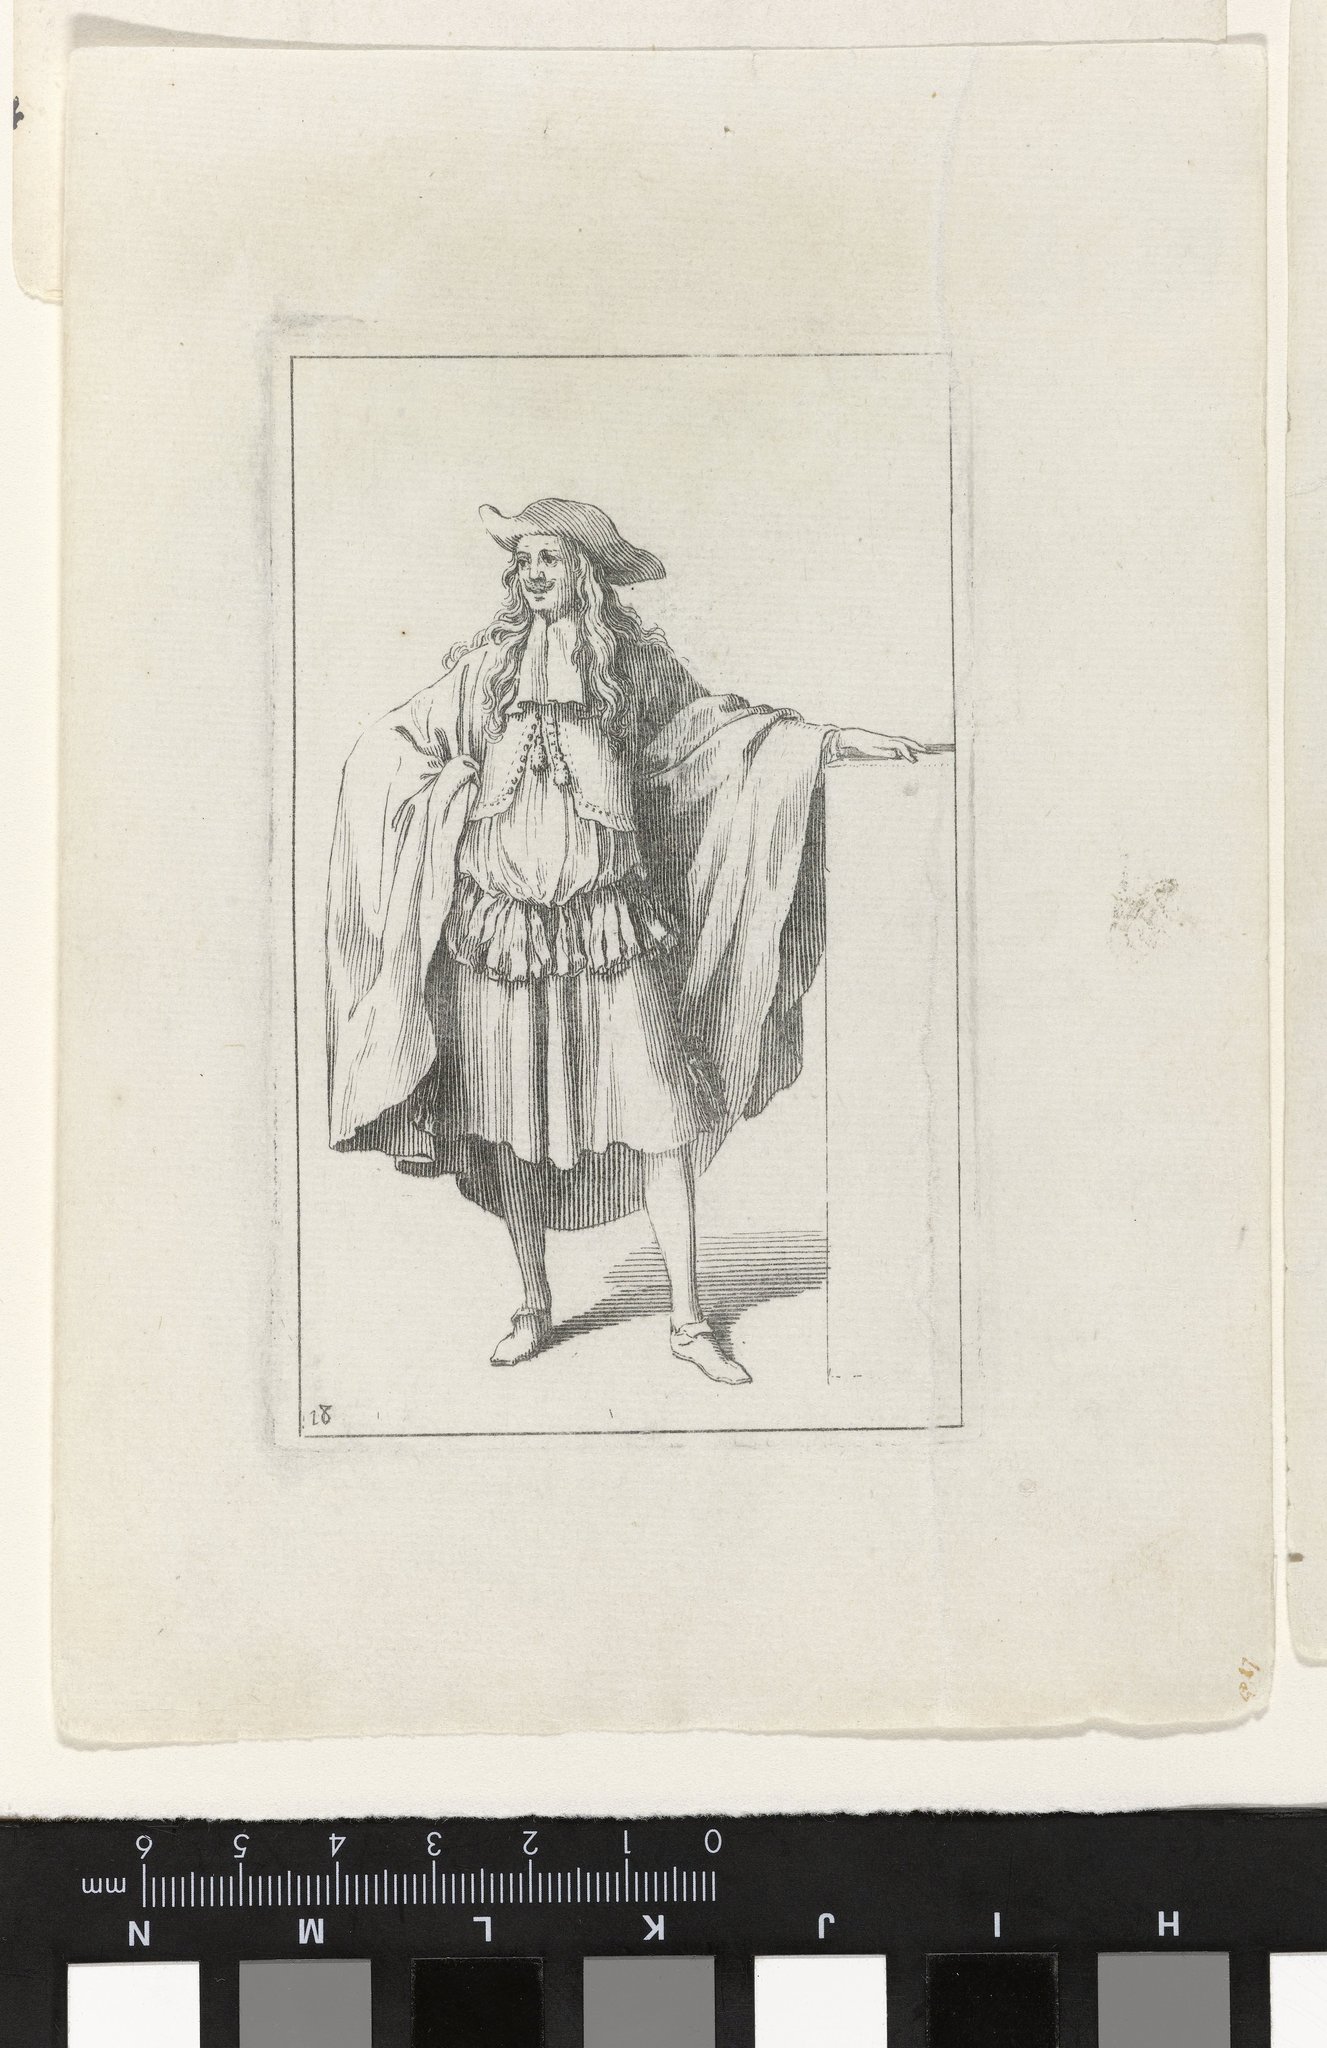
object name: print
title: Man bij muurtje, gekleed in een rhingrave kostuum en wijde mantel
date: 1685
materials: paper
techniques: etching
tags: clothing for the upper part of the body (with name) (+ men's clothes), neck-gear: jabot (+ men's clothes), styles of hairdress (allonge), coat (+ men's clothes), clothing for the upper part of the body (innocent) (+ men's clothes), head-gear: hat (+ men's clothes), shoes, sandals (+ men's clothes), clothes, costume (+ men's clothes), clothing for the upper part of the body (doublet) (+ men's clothes), stockings, socks (+ men's clothes), trousers, breeches, etc. (petticoat breeches) (+ men's clothes)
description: Staande man gekleed in een rhingrave kostuum, bestaande uit een kort wambuis (innocent), rechthoekige bef met akertjes, hemd, wijde kniebroek met aan weerszijden linten en kousen. Om de schouders en armen is een wijde mantel gedrapeerd. Hoed met brede slappe rand op het allongekapsel. Platte schoenen. Deze prent is de 5de staat van nummer 18, en behoort tot een serie van ca. 24 kostuumprenten, uit Figures a la mode dédiées a Mr Le Duc de Bourgogne, uitgegeven door Etienne Jeaurat, Parijs, ca. 1685.